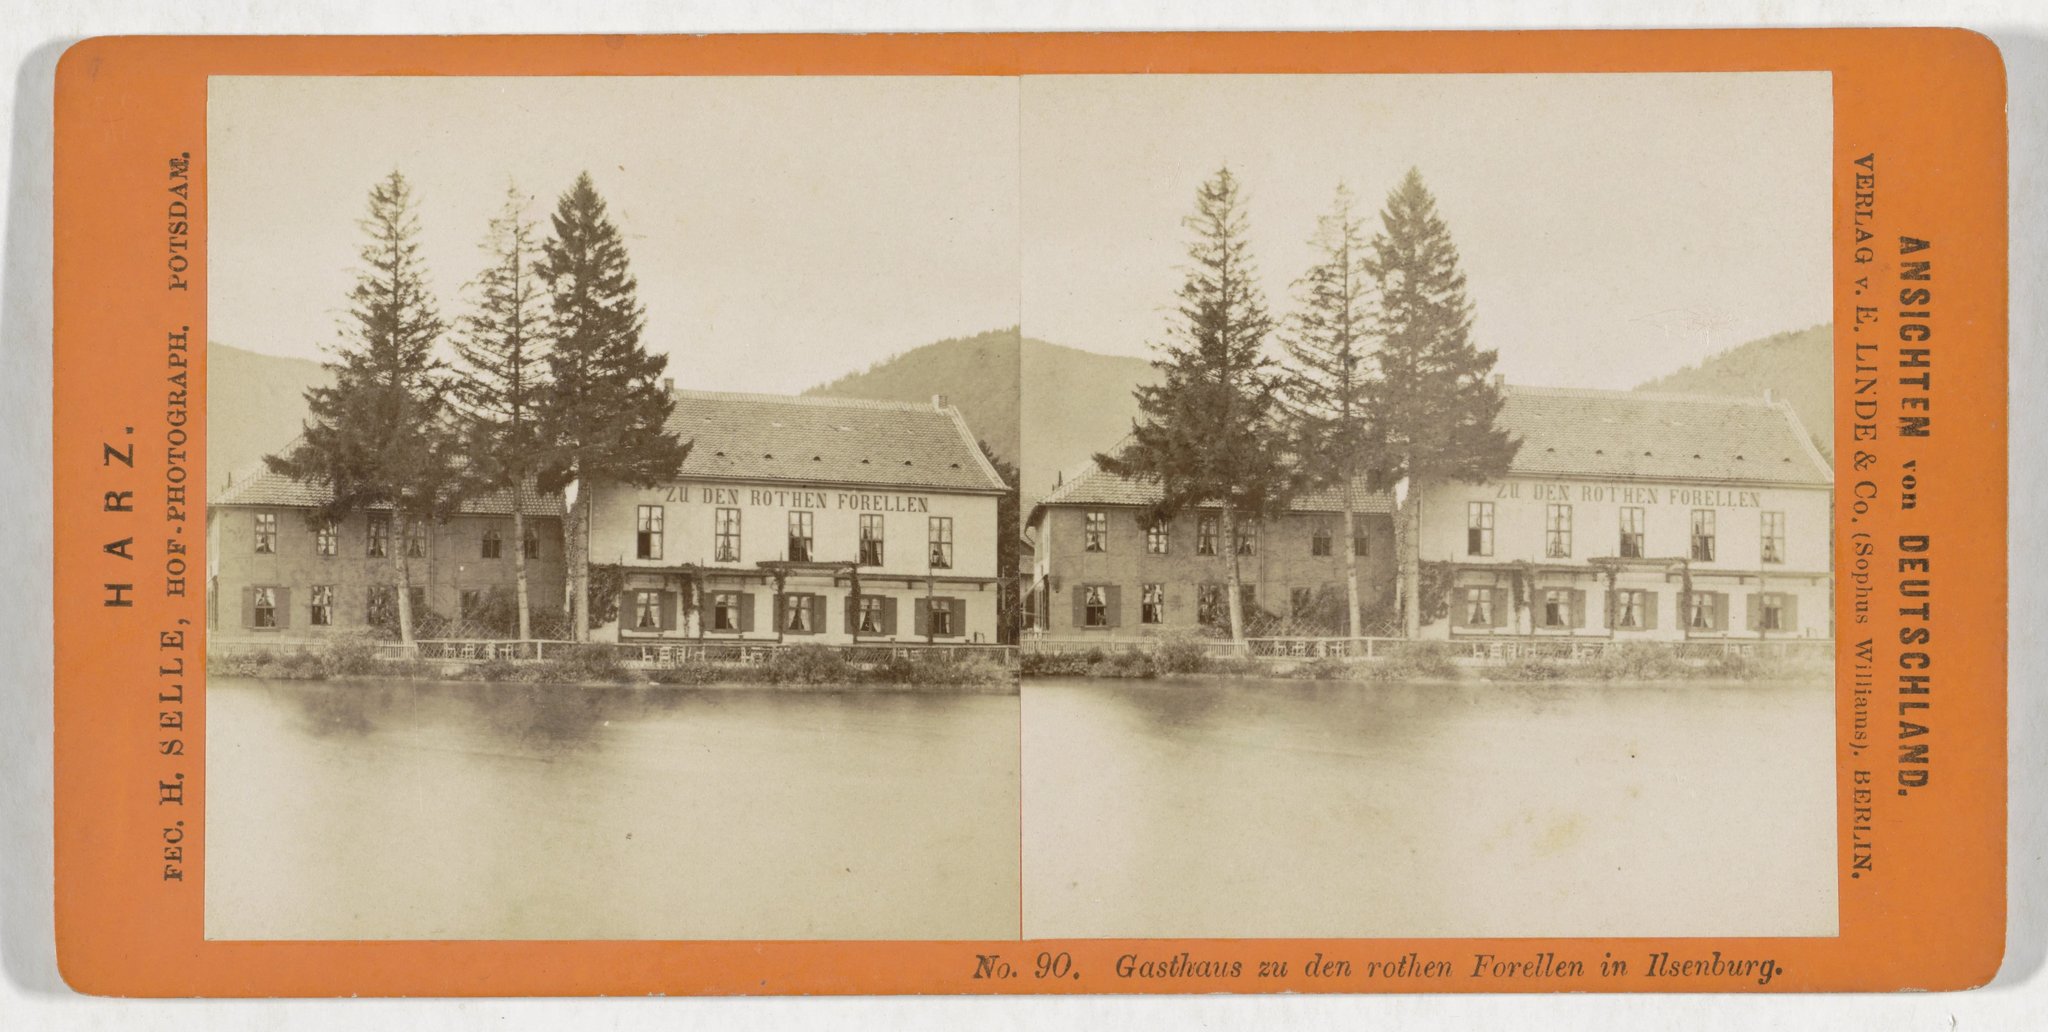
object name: stereograph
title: Ansichten von Deutschland / Harz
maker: hermann selle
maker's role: fotograaf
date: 1868-1890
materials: cardboard, paper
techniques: albumen print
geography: berlin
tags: hotel, hostelry, inn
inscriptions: inscription: ‘Hof-Photograph. Potsdam.’, number: ‘No. 90.’